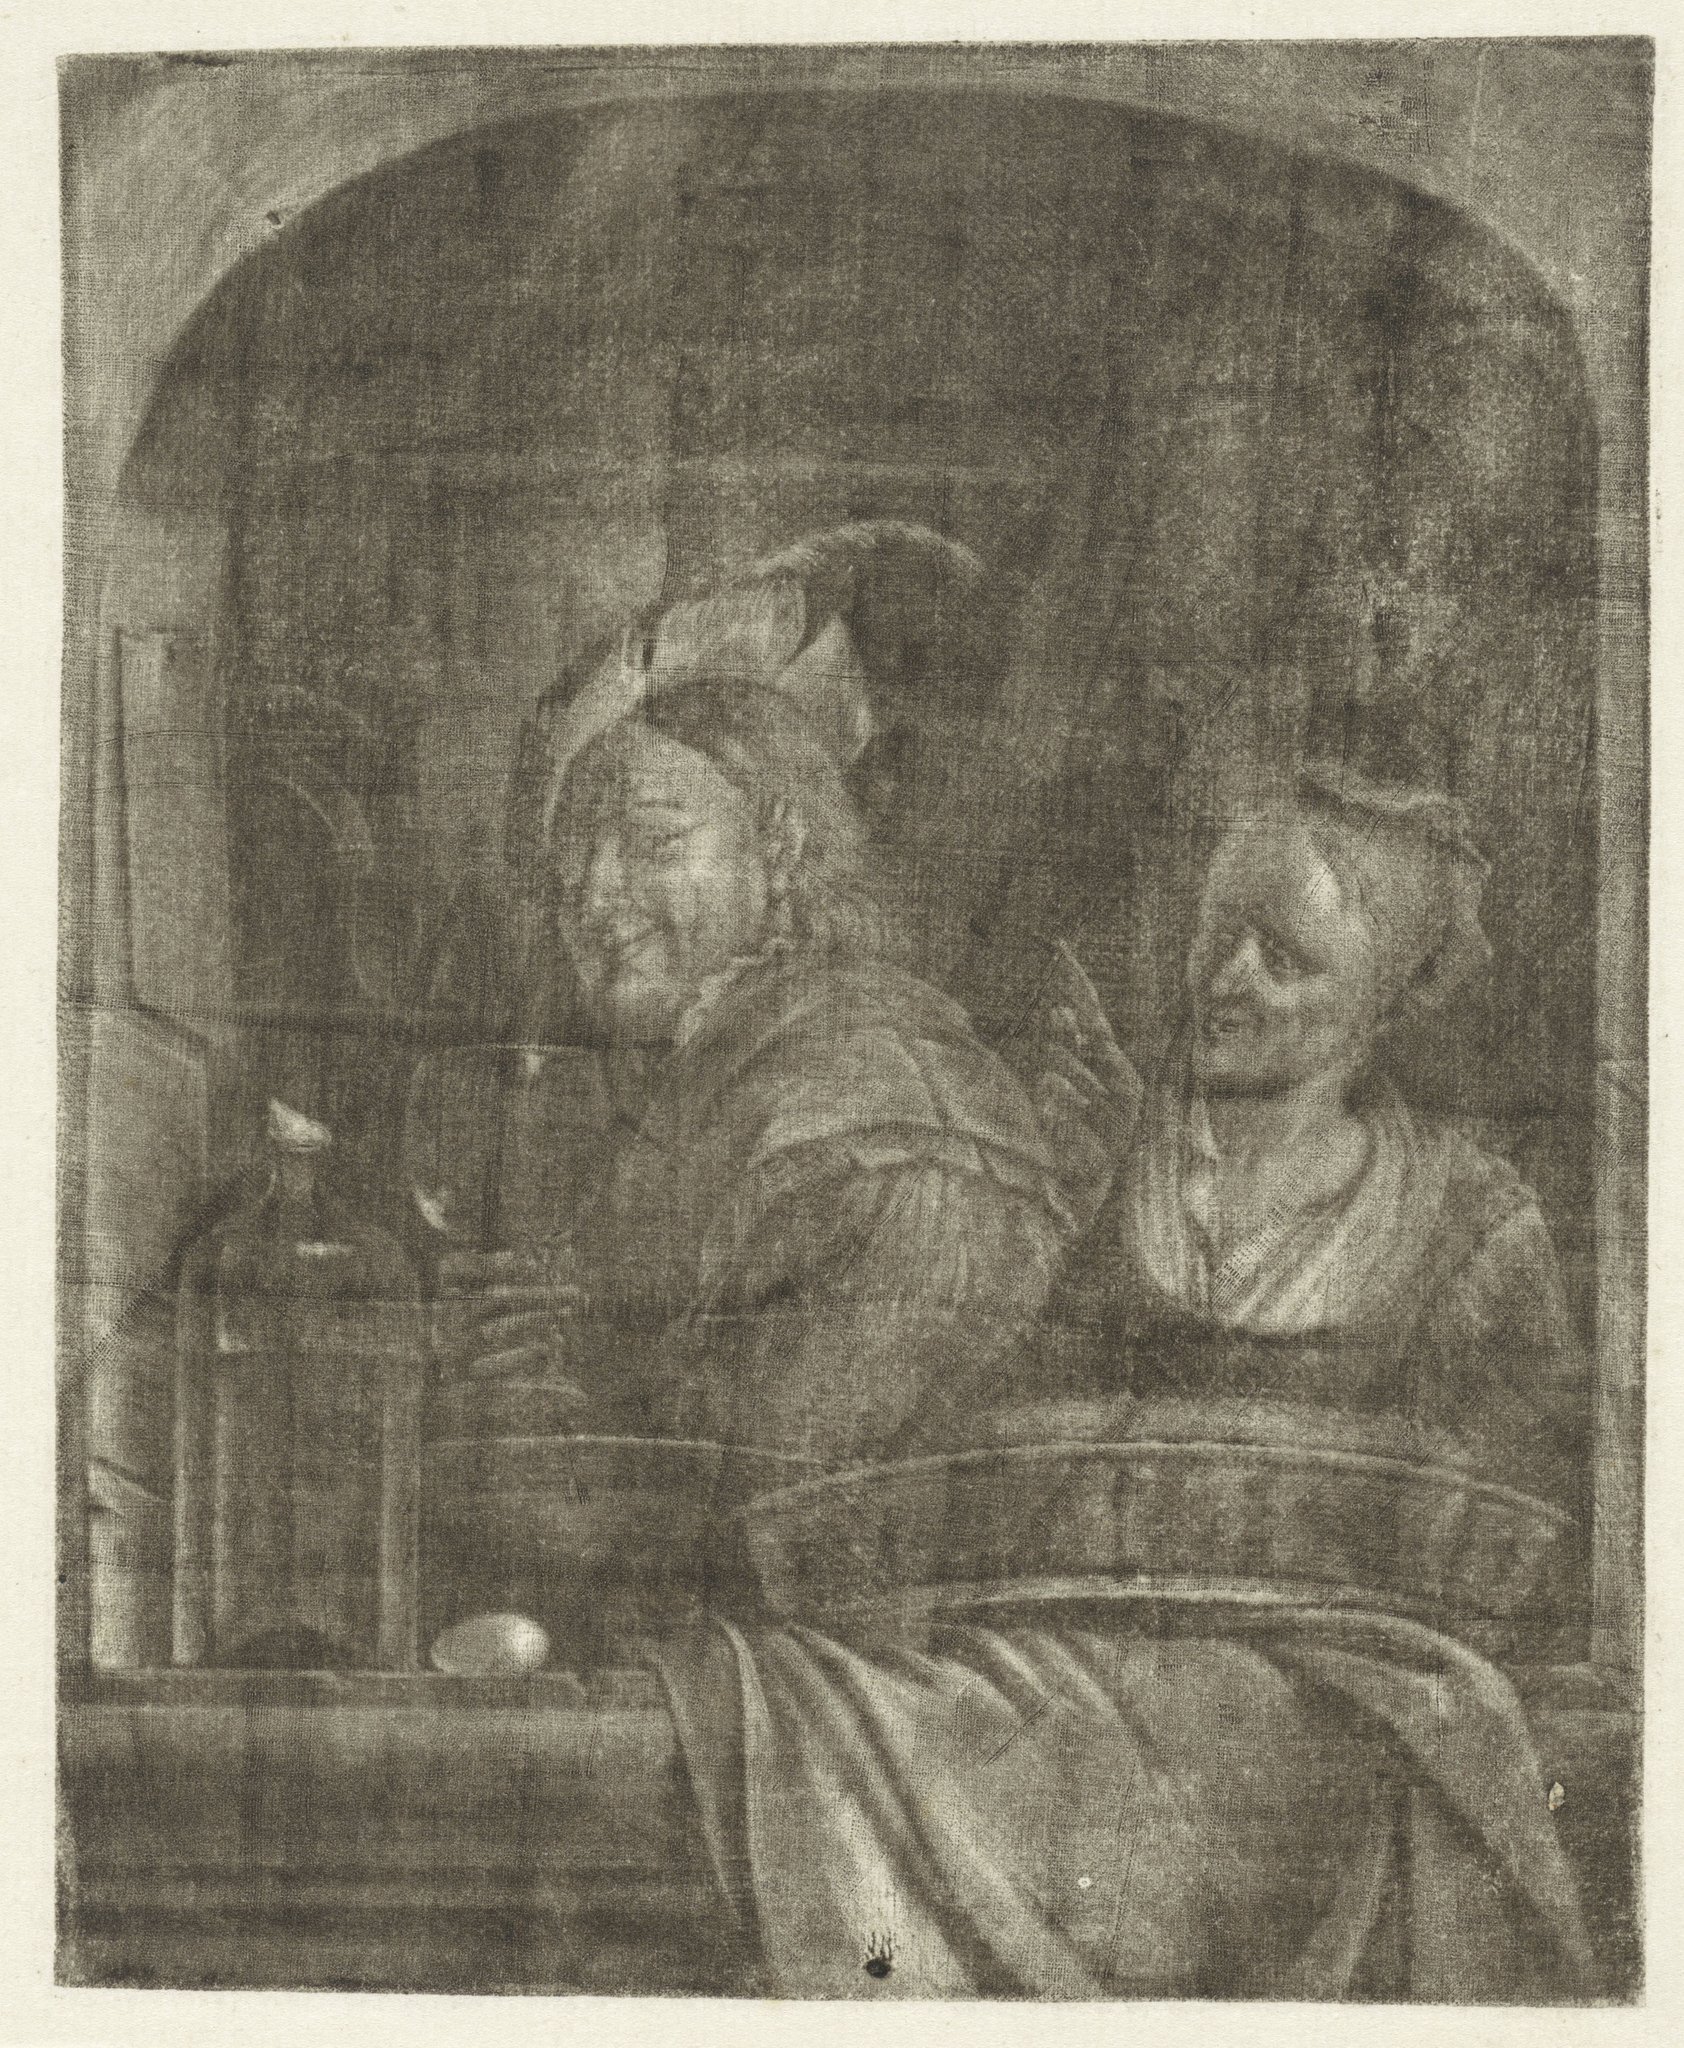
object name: print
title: Man en vrouw in een venster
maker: aert schouman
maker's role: draughtsman, painter, print maker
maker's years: 1710-1792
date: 1720-1792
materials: paper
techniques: mezzotint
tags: alcoholic drinks, eggs, egg-dishes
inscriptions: collector's mark: Lugt 240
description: Een man met een glas en een wijzende vrouw in een venster. Op de vensterbank een fles, een ei en een schaal.